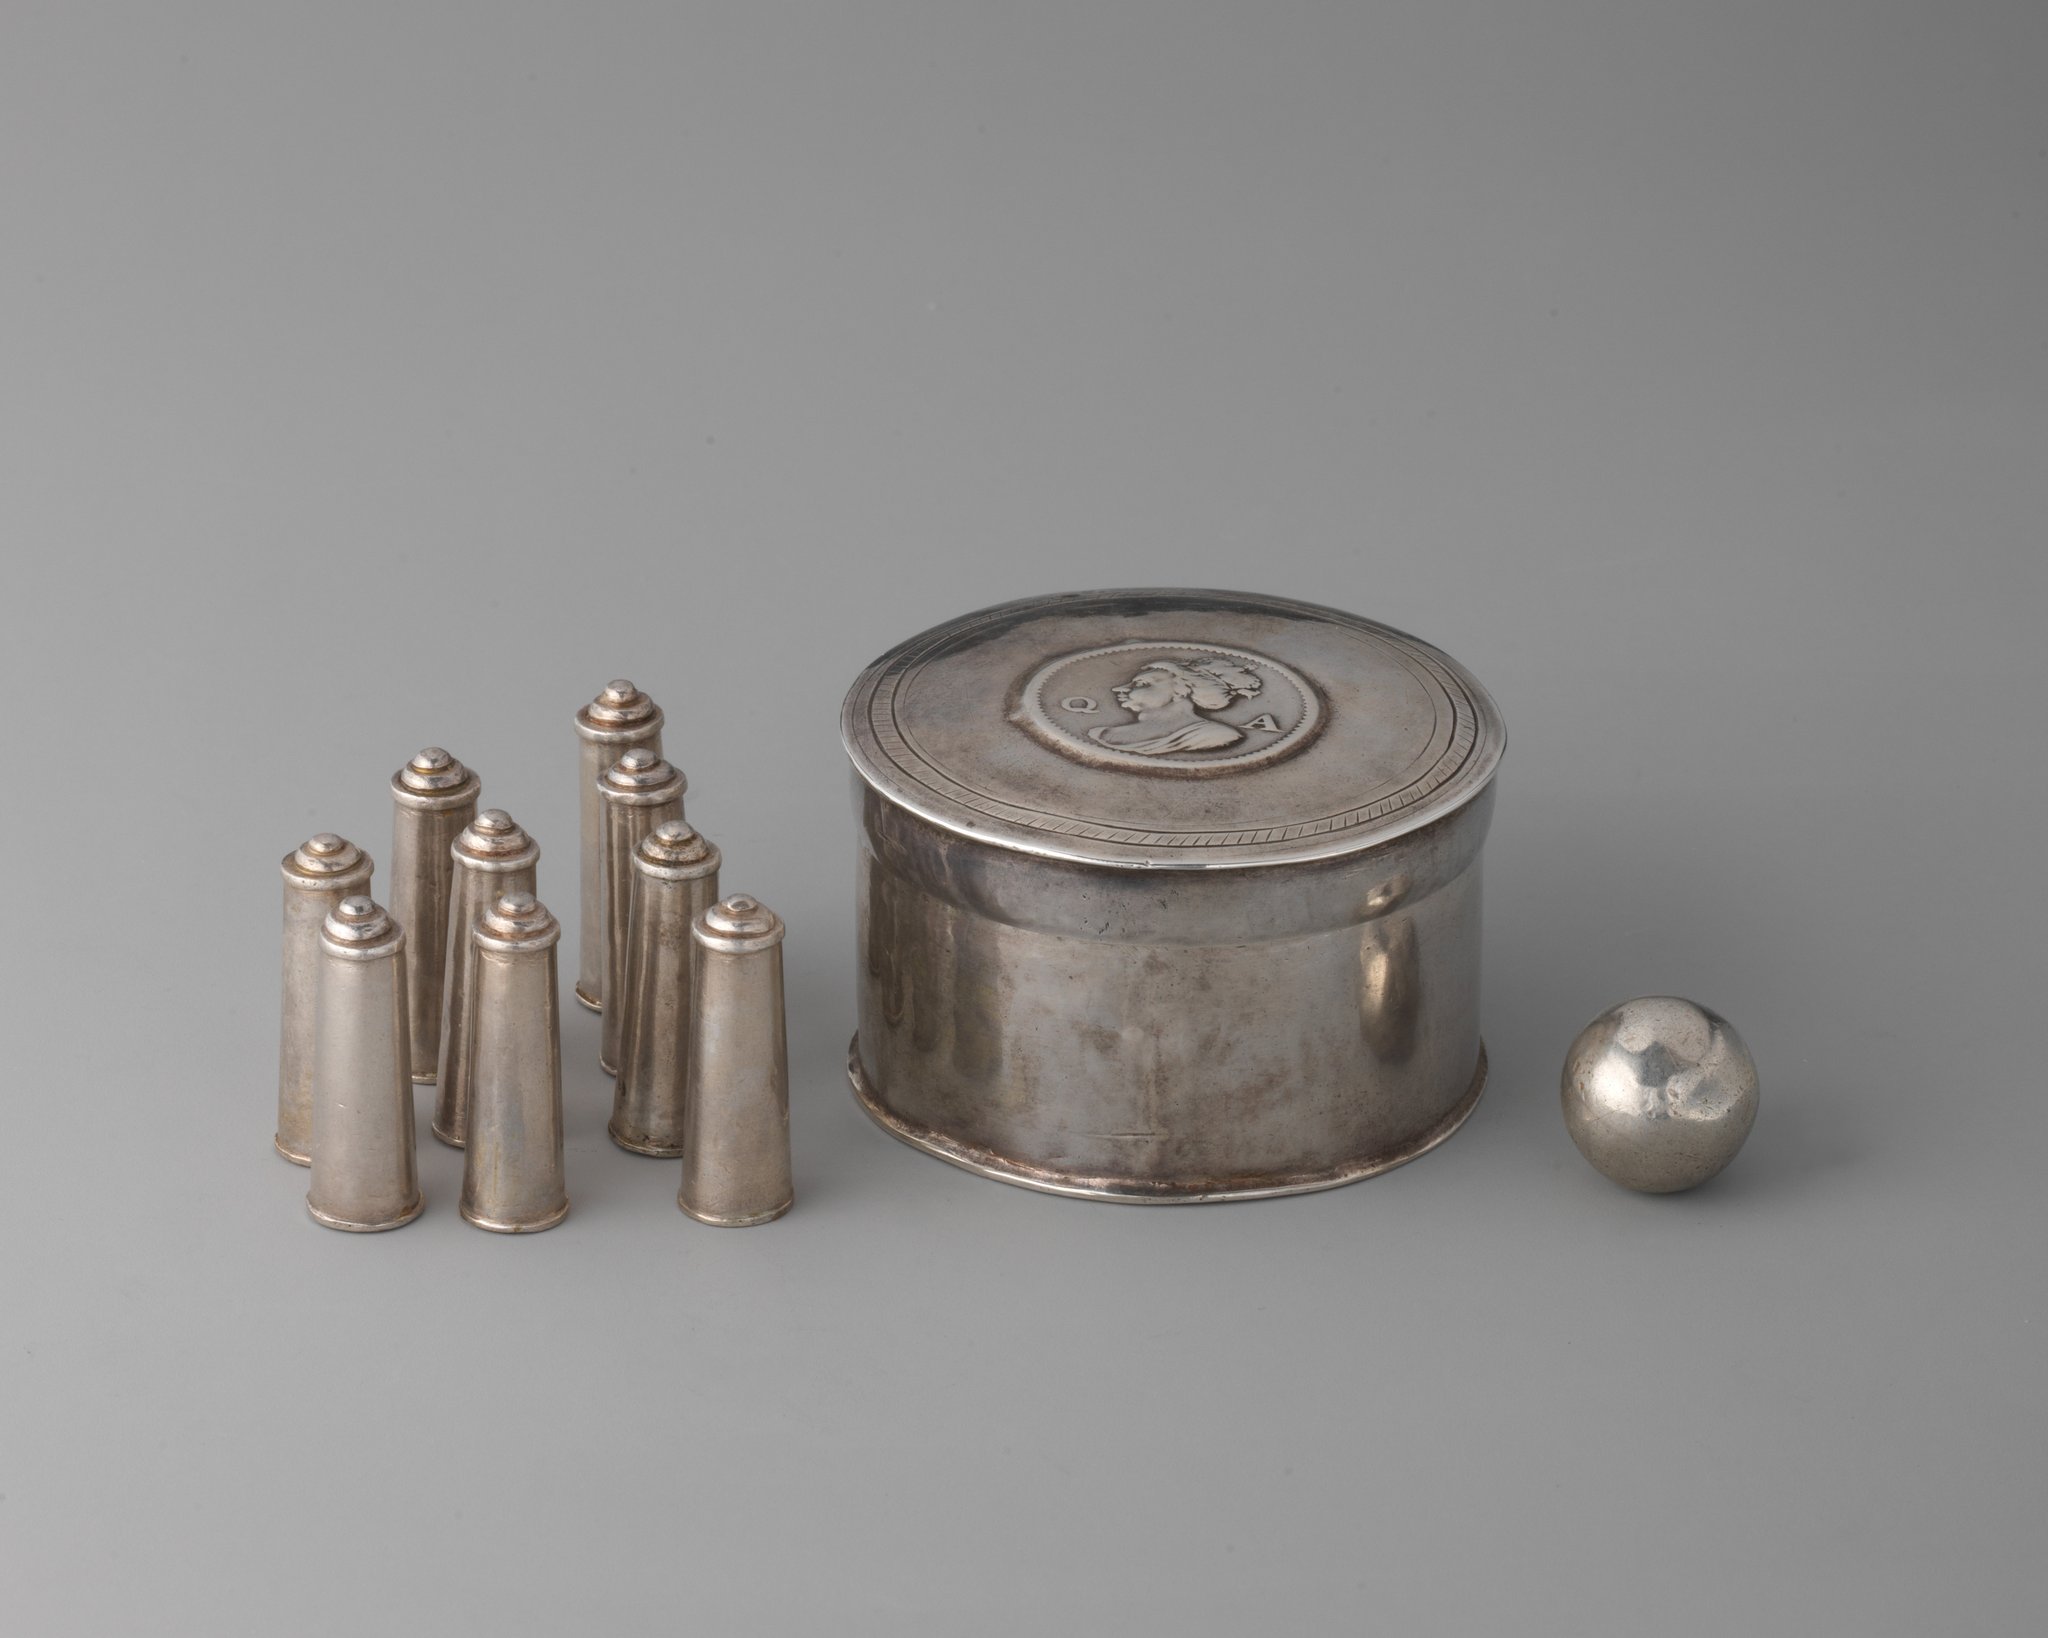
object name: ball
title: Miniature ball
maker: t.k., london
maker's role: maker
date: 1702-1714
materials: silver